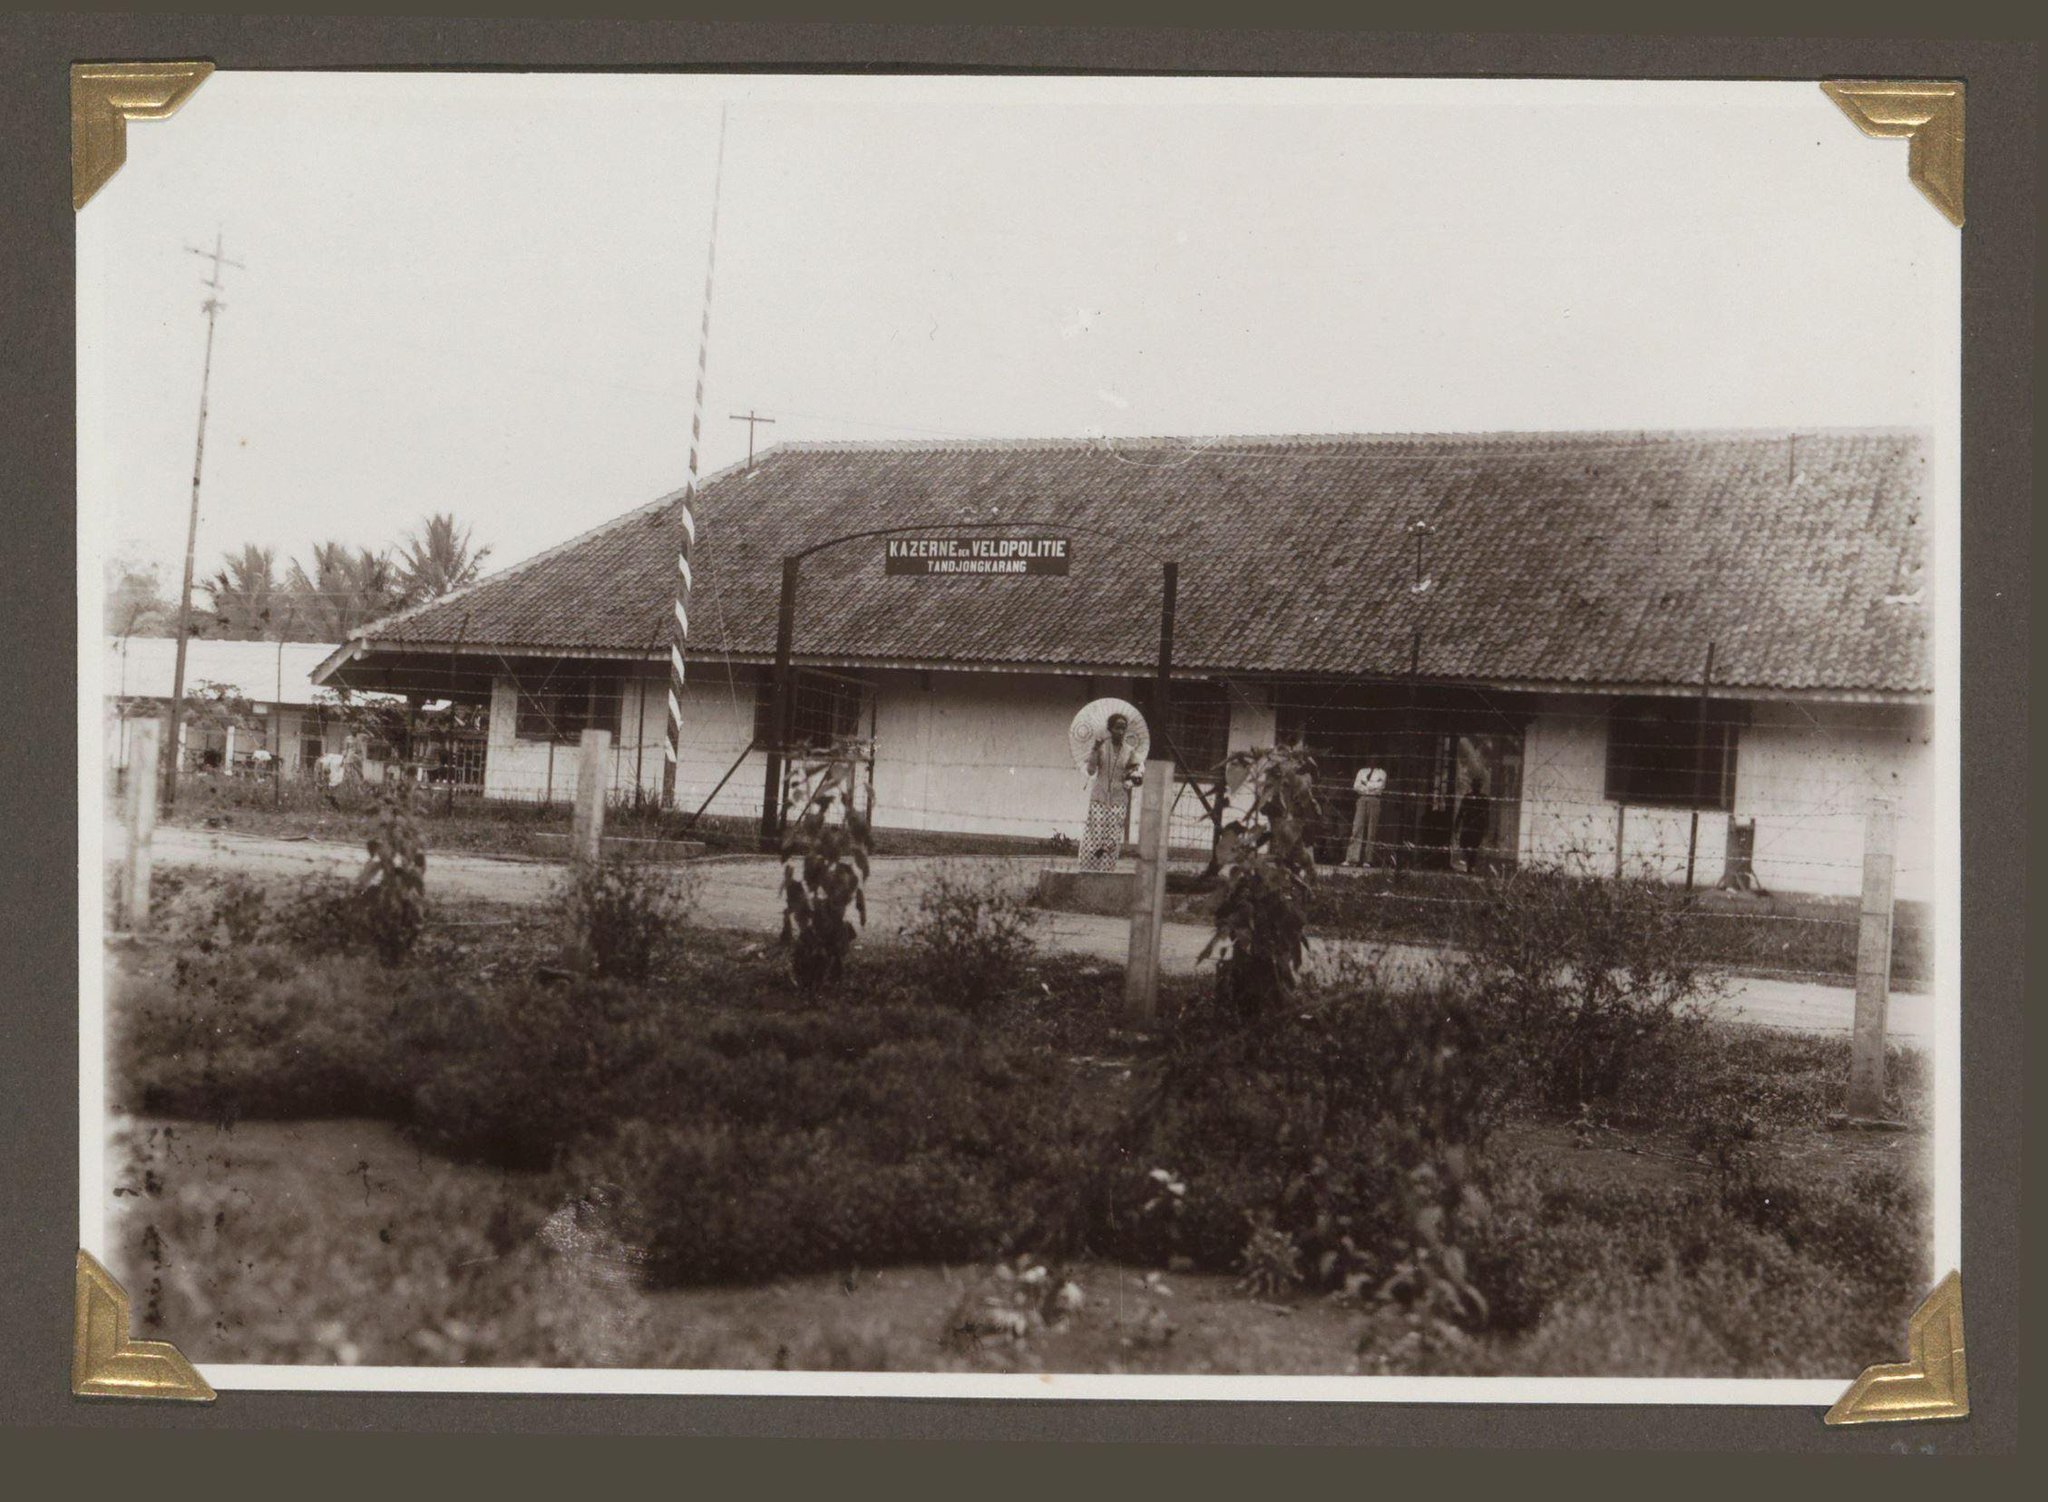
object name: photograph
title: De ingang van de kazerne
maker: Anonymous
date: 1932-1933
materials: photographic support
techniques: gelatin silver print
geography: lampung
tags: gate, entrance, barracks, police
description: Onderdeel van Herinneringsalbum voor F.J. Junius, vertrekkend resident van Lampong (Zuid-Sumatra).